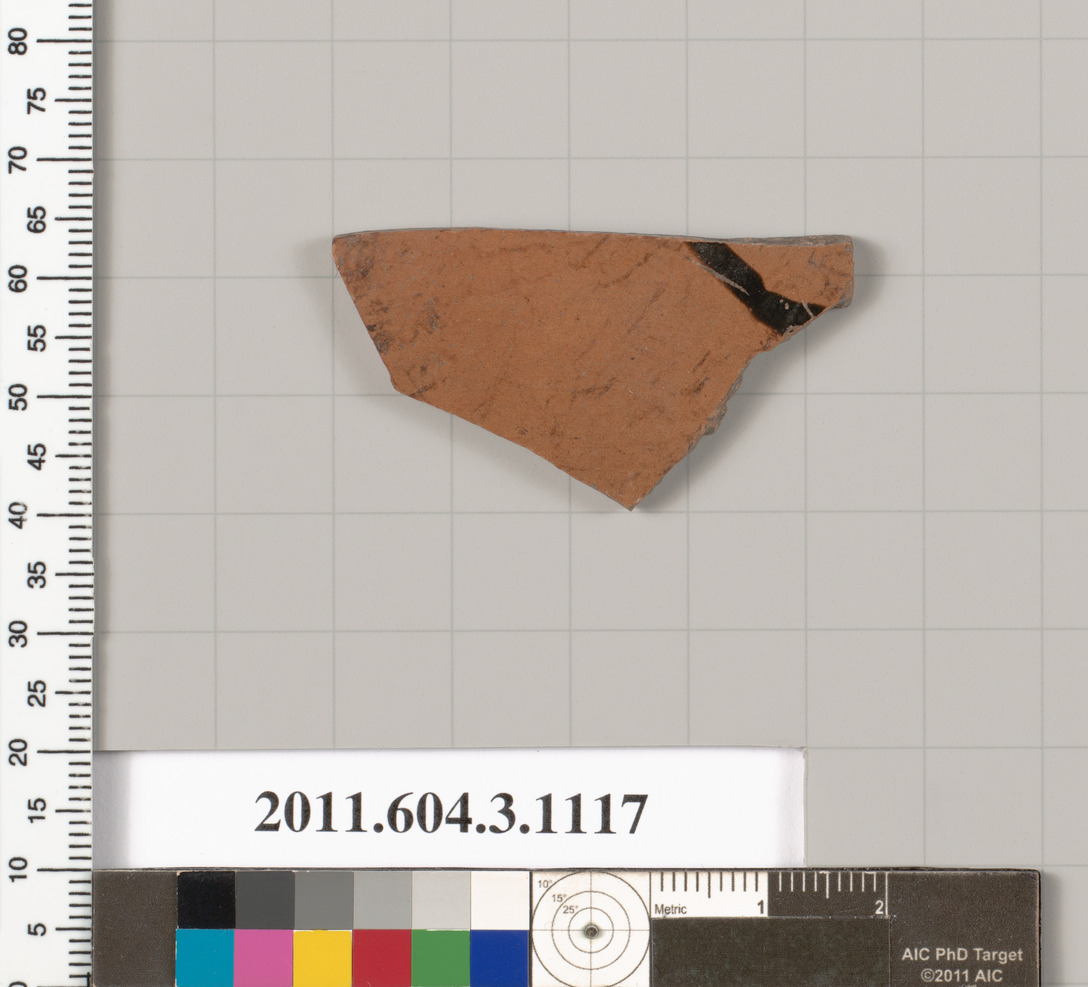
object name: mastoid or kyathos fragment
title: Terracotta fragment of a mastoid (drinking cup with narrow base) or a kyathos (cup-shaped ladle)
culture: greek, attic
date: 534-468 BCE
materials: terracotta